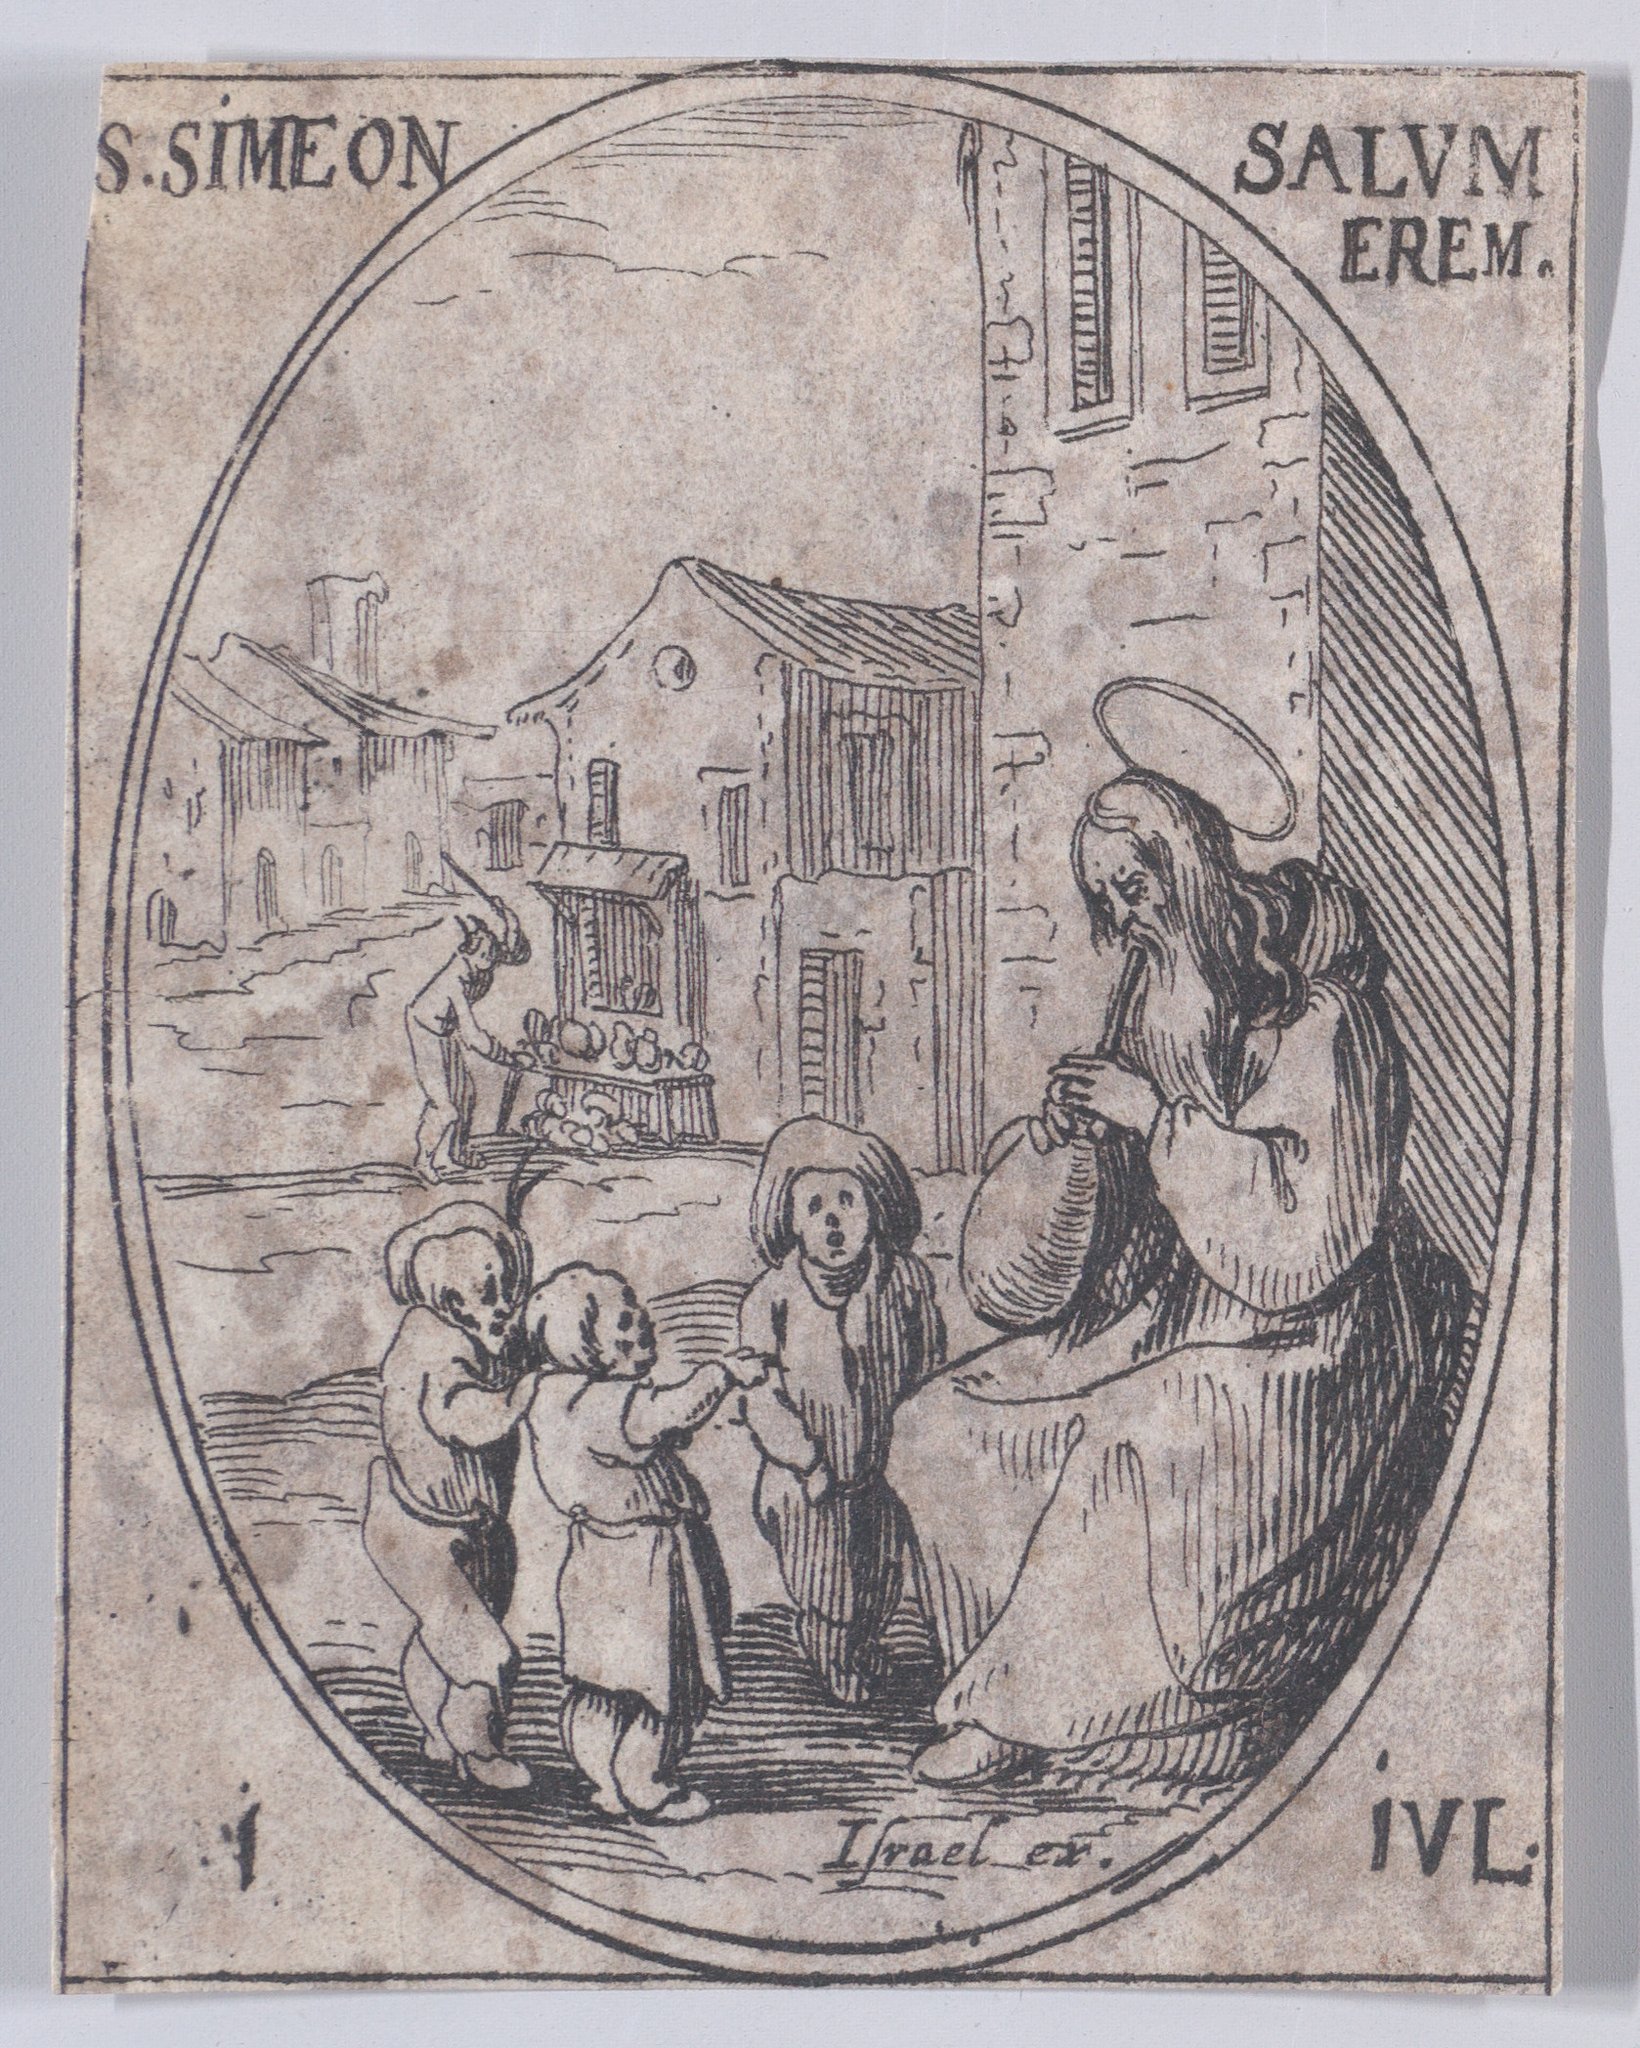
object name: print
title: S. Siméon Salus, évêque (St. Simeon Salus, Bishop), July 1st, from "Les Images De Tous Les Saincts et Saintes de L'Année" (Images of All of the Saints and Religious Events of the Year)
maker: jacques callot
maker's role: artist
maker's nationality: french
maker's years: 1592-1635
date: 1636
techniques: etching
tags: men,saints